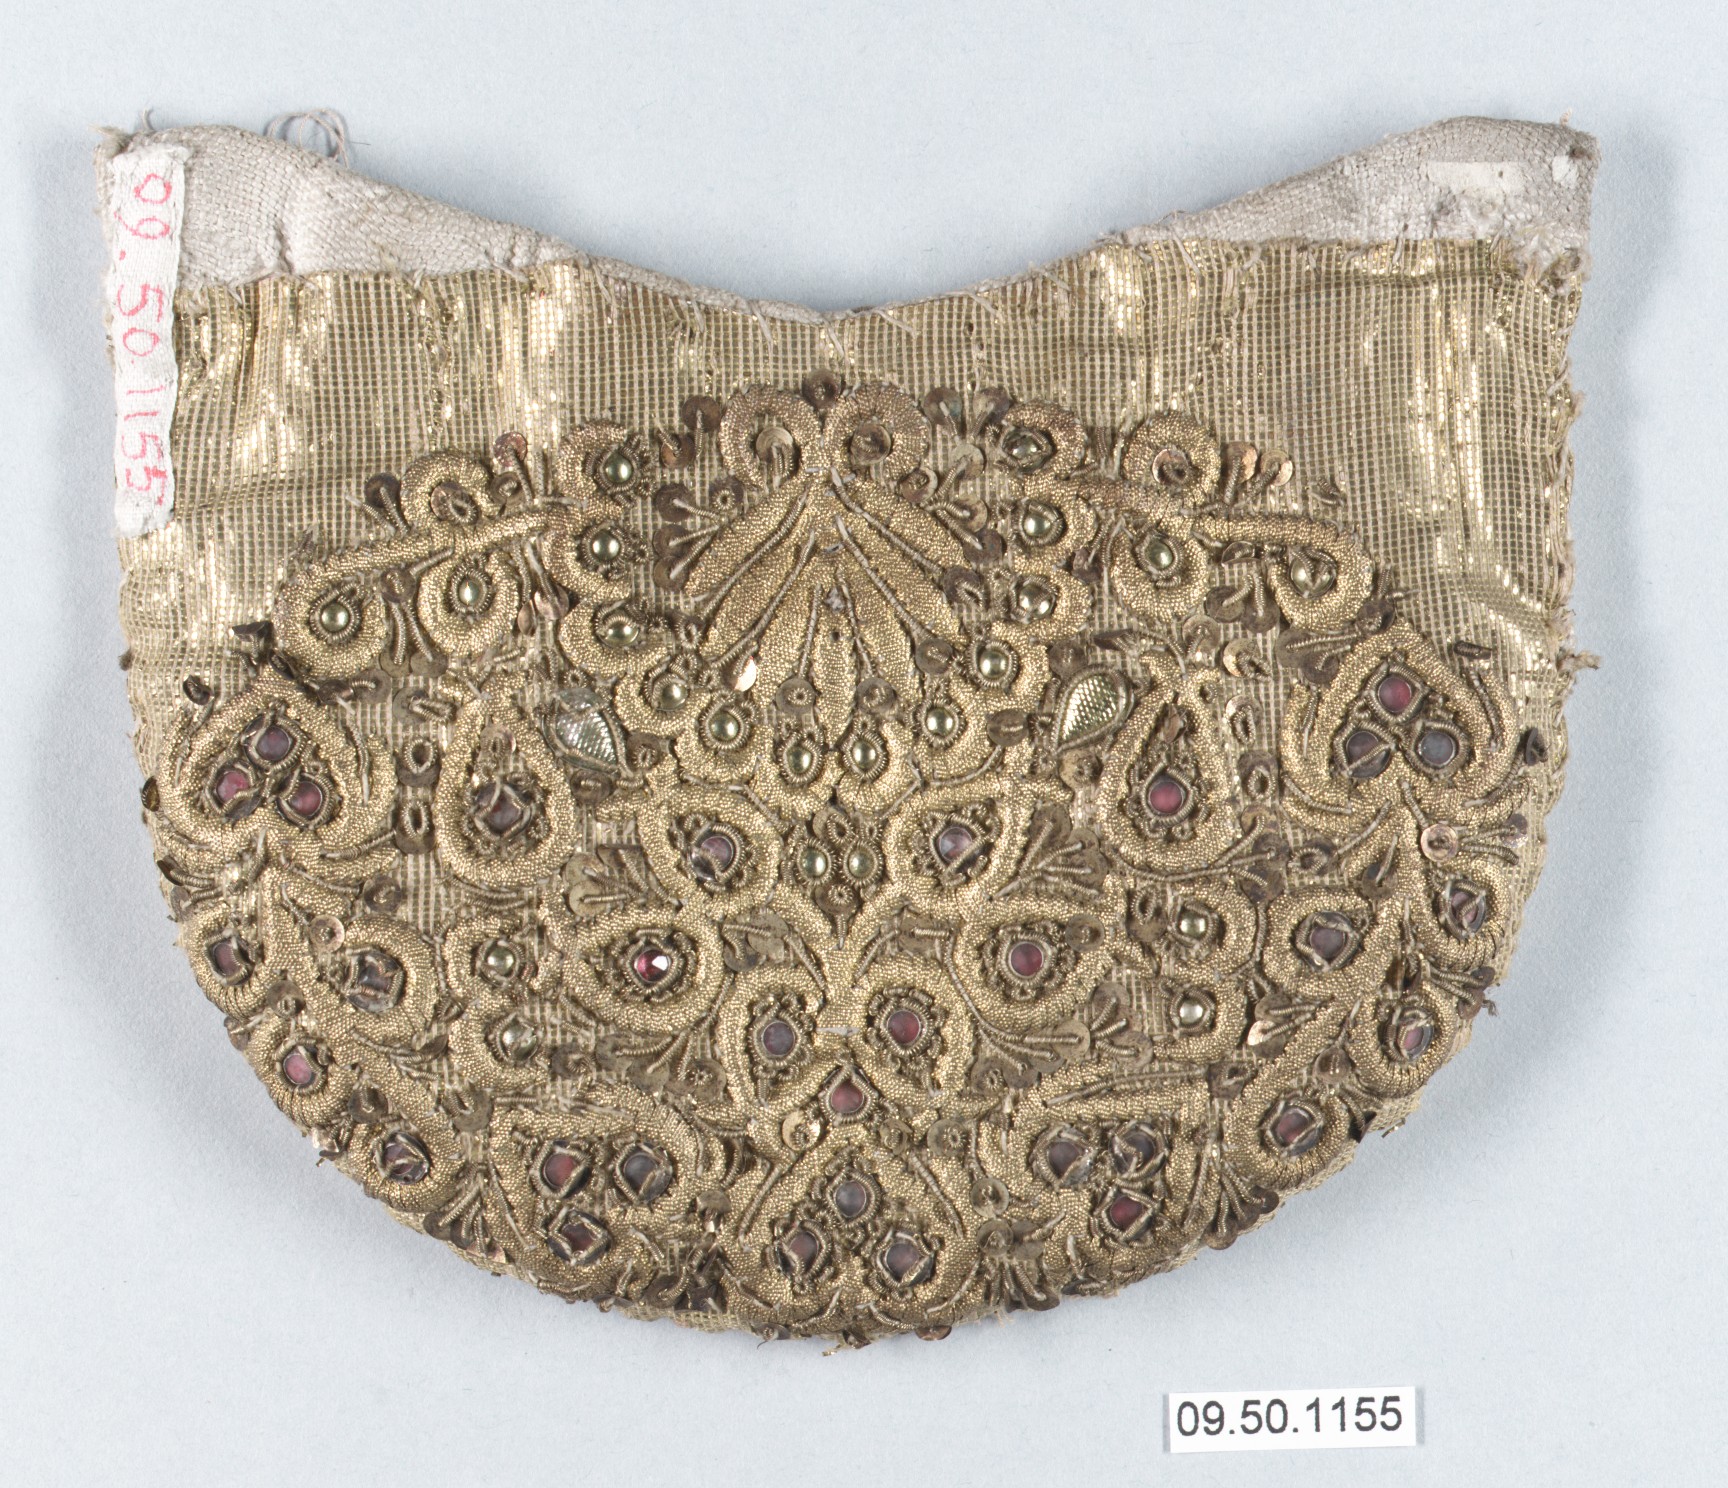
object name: cap crown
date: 1801-1900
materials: glass, linen, metal